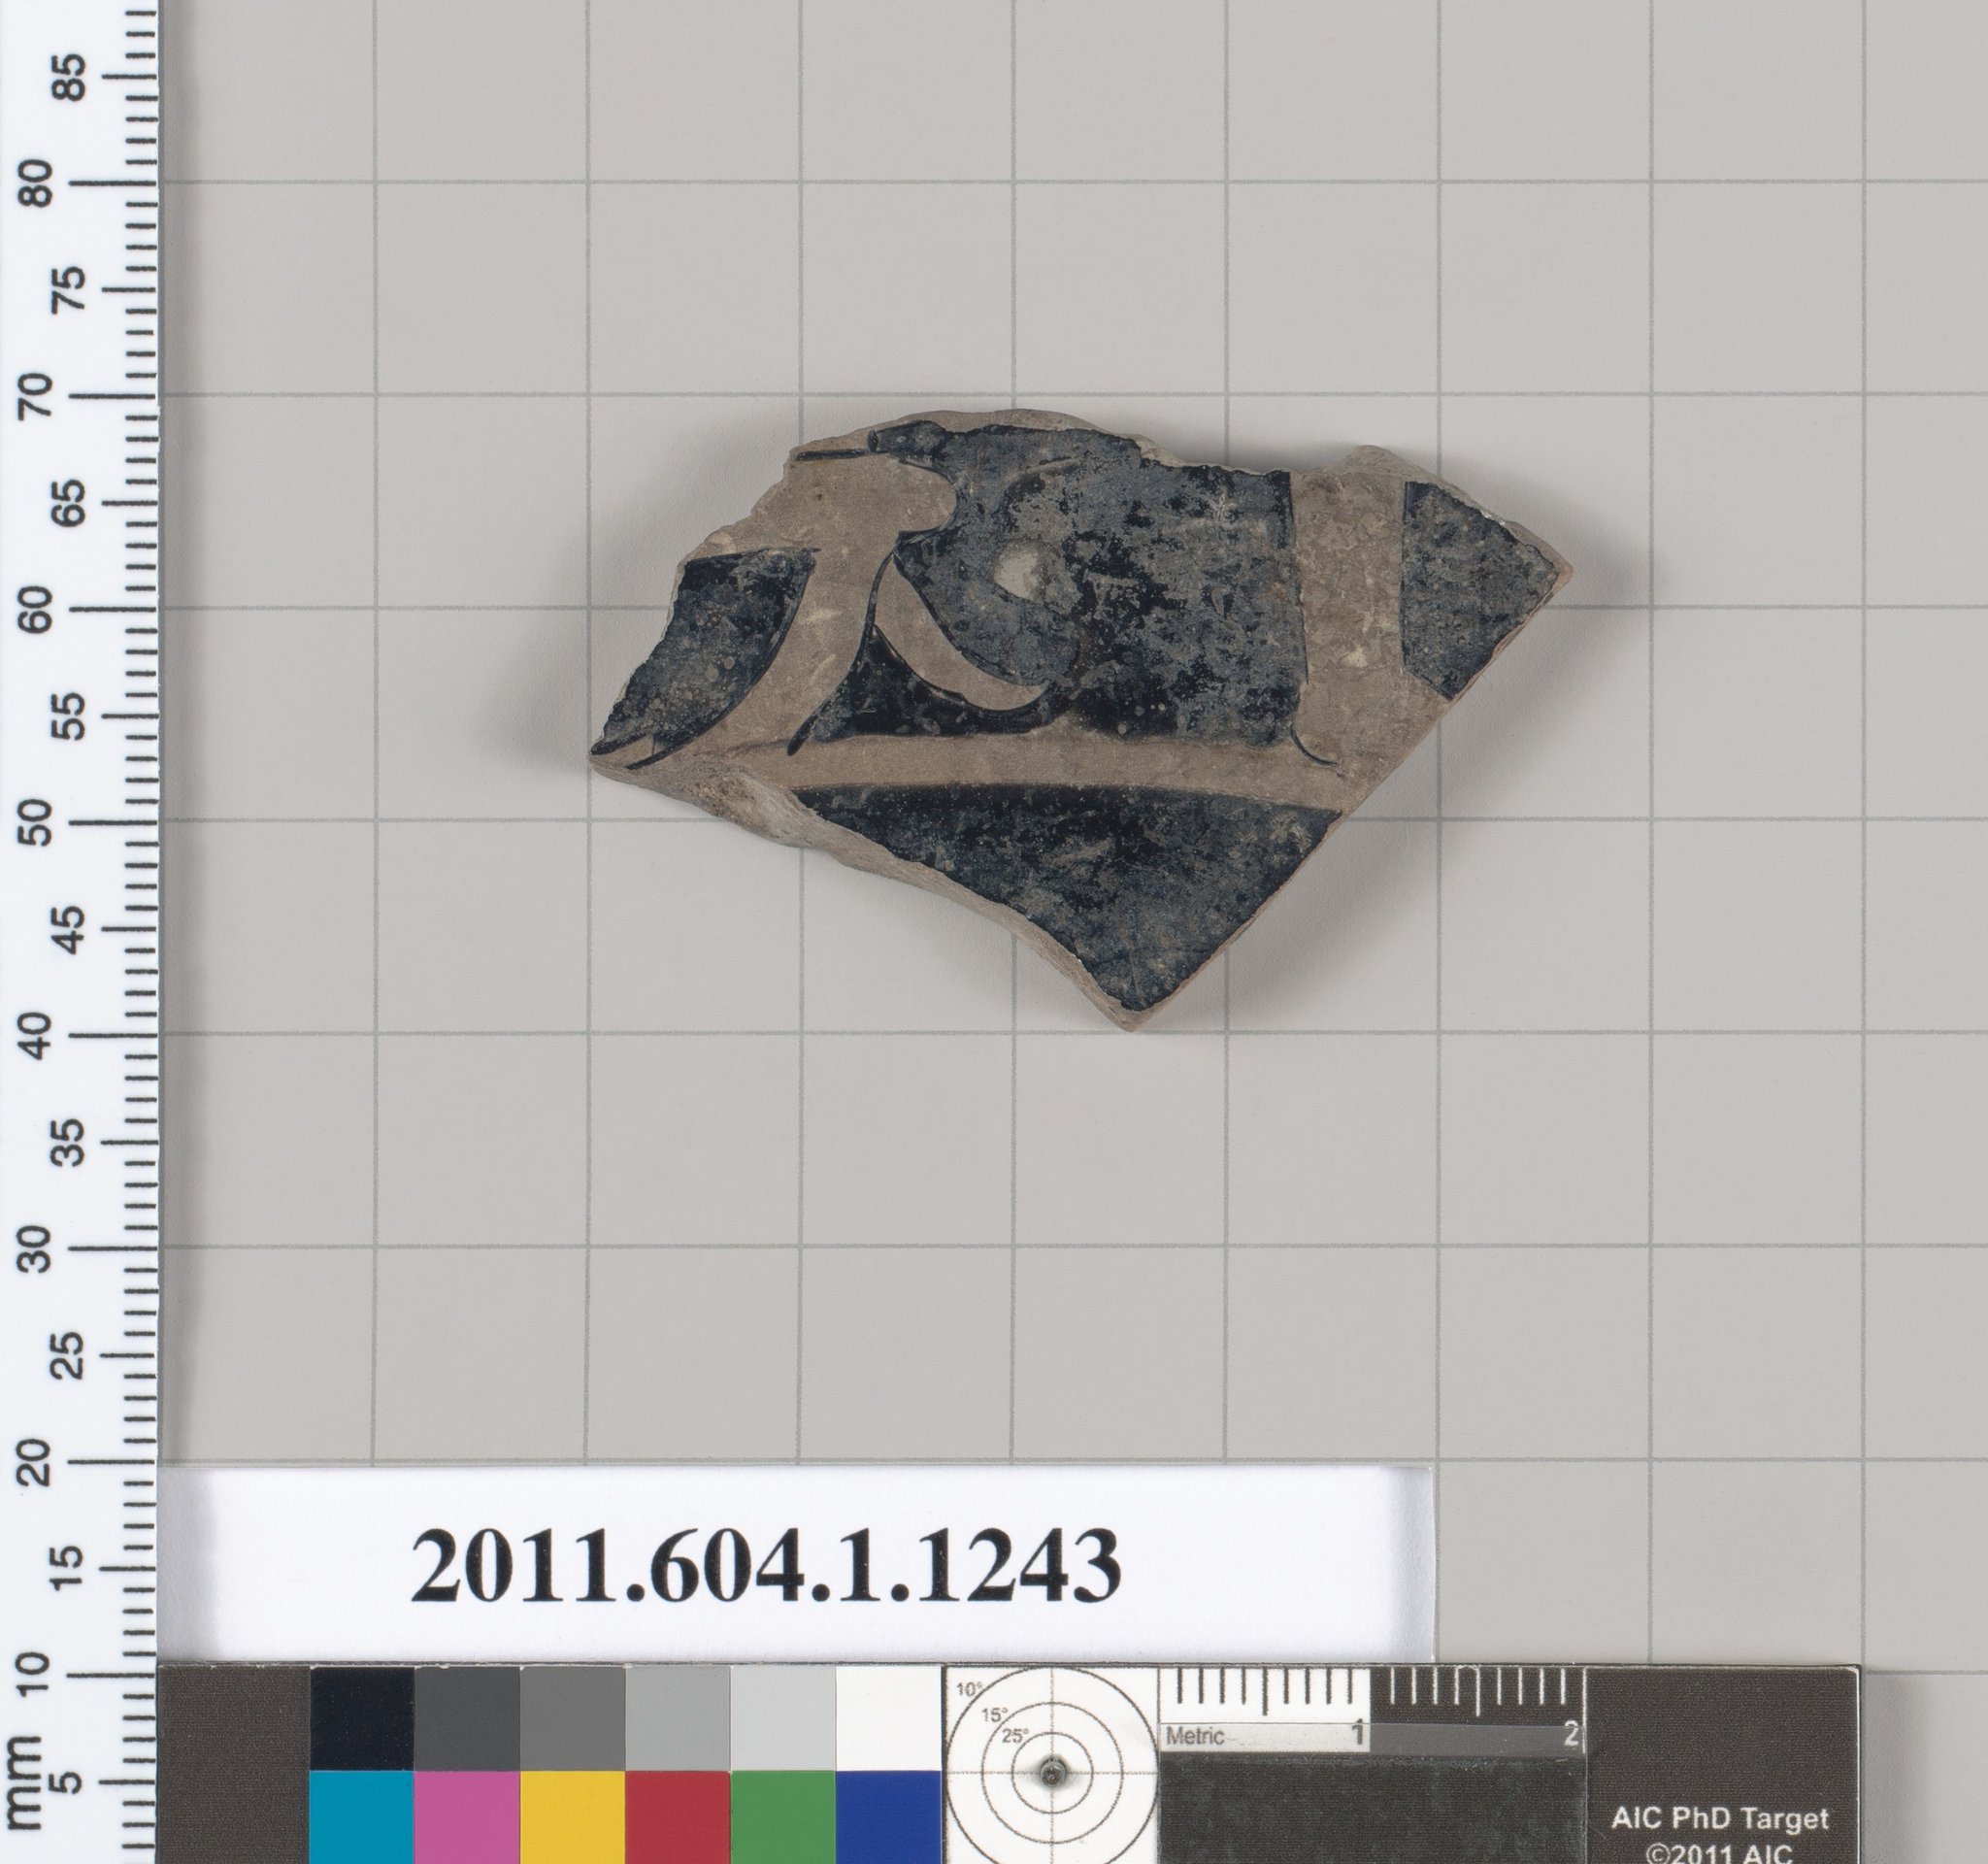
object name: kylix fragment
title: Terracotta fragment of a kylix (drinking cup)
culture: greek, attic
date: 520-500 BCE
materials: terracotta